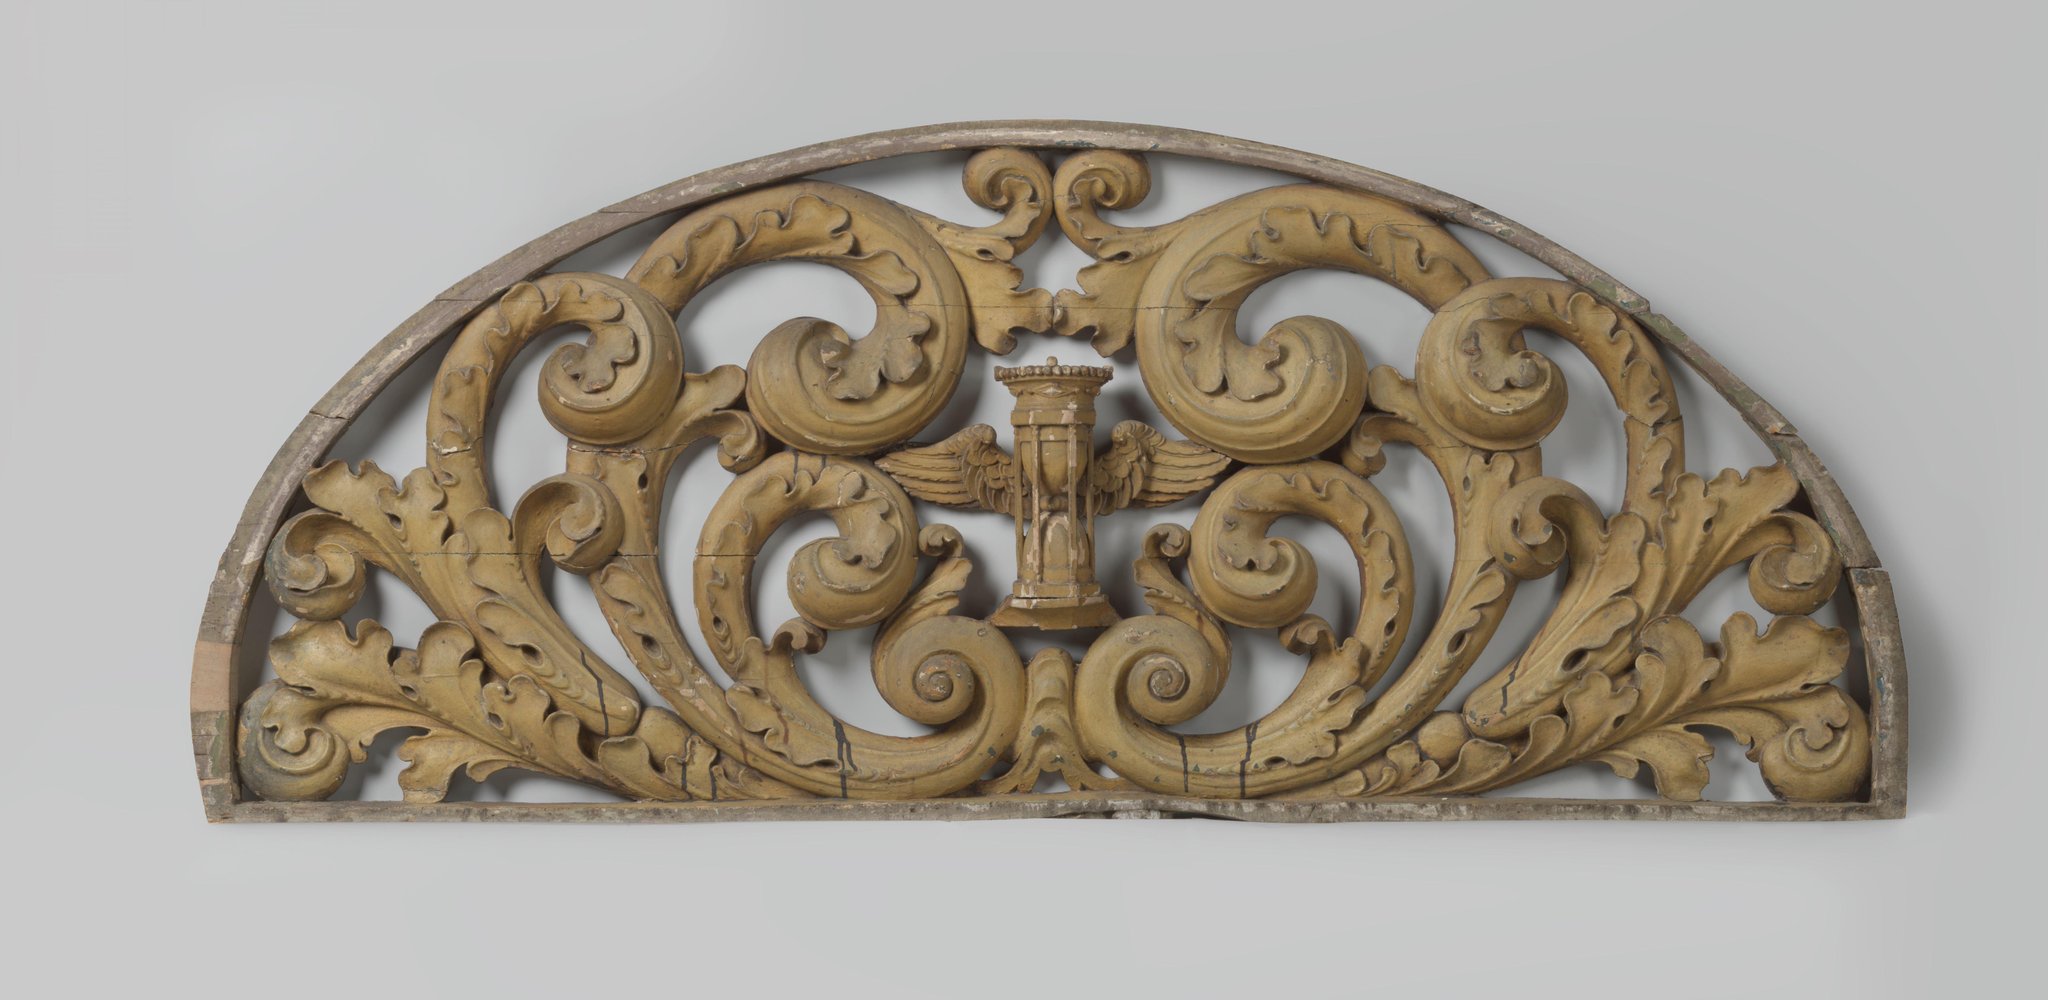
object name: transom window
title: Bouwfragment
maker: Anonymous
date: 1650-1700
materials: wood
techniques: painted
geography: northern netherlands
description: Bovenlicht van geel geverfd hout met arabesken en een zandloper.